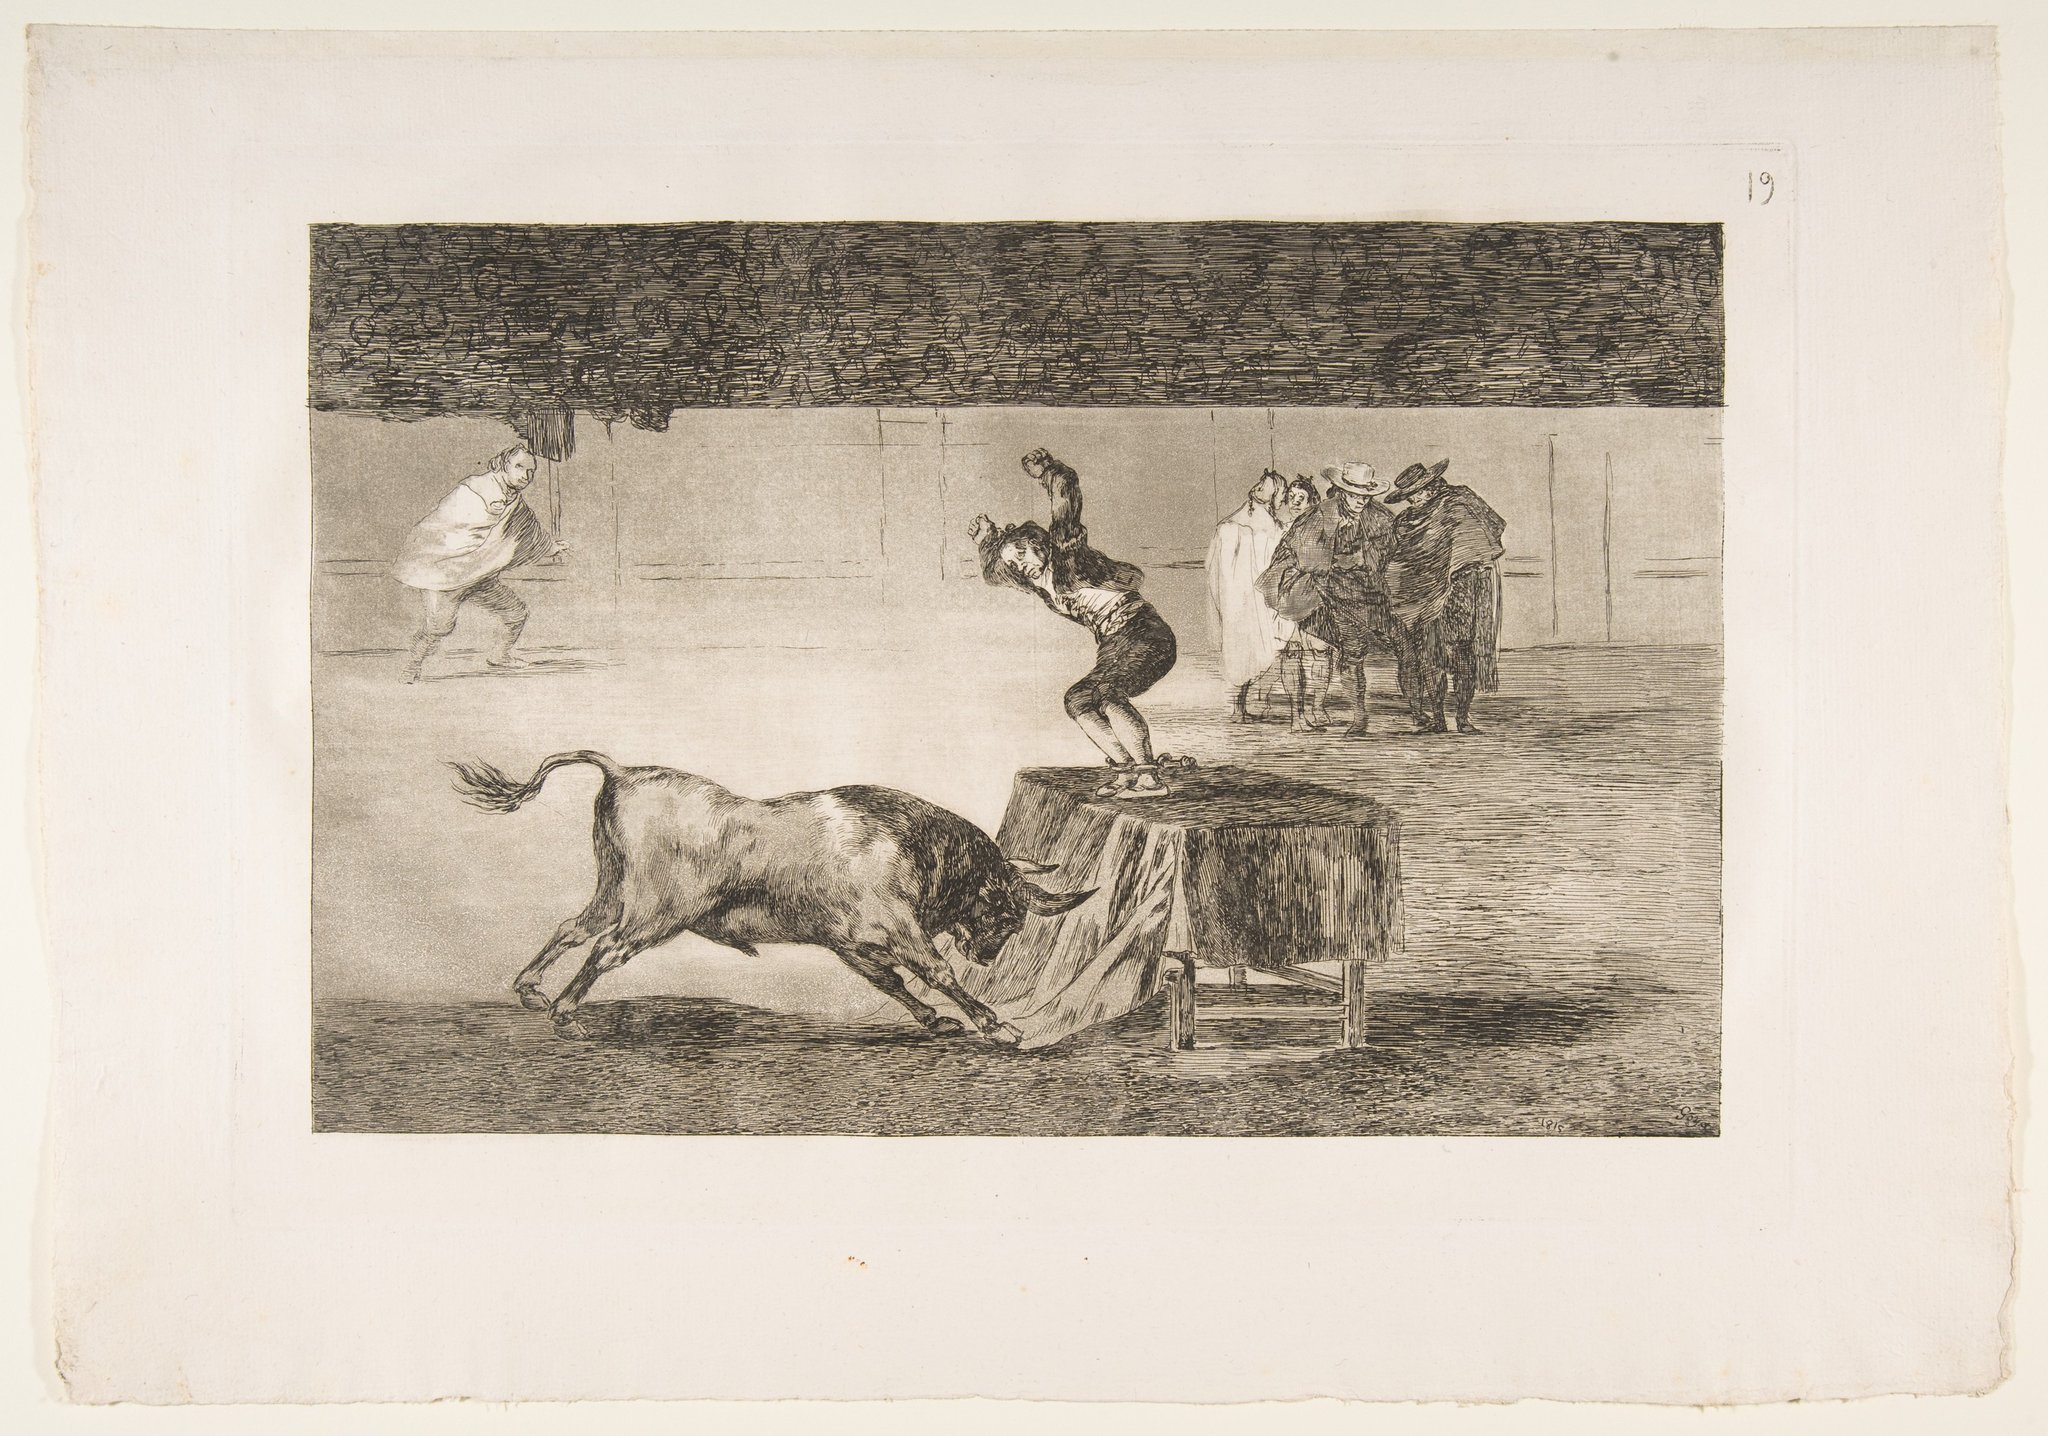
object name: print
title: Plate 19 of "La Tauromaquia": Another madness of his in the same ring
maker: goya (francisco de goya y lucientes)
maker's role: artist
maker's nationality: spanish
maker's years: 1746-1828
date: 1816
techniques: aquatint, engraving, burnishing, drypoint, etching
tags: men,bulls